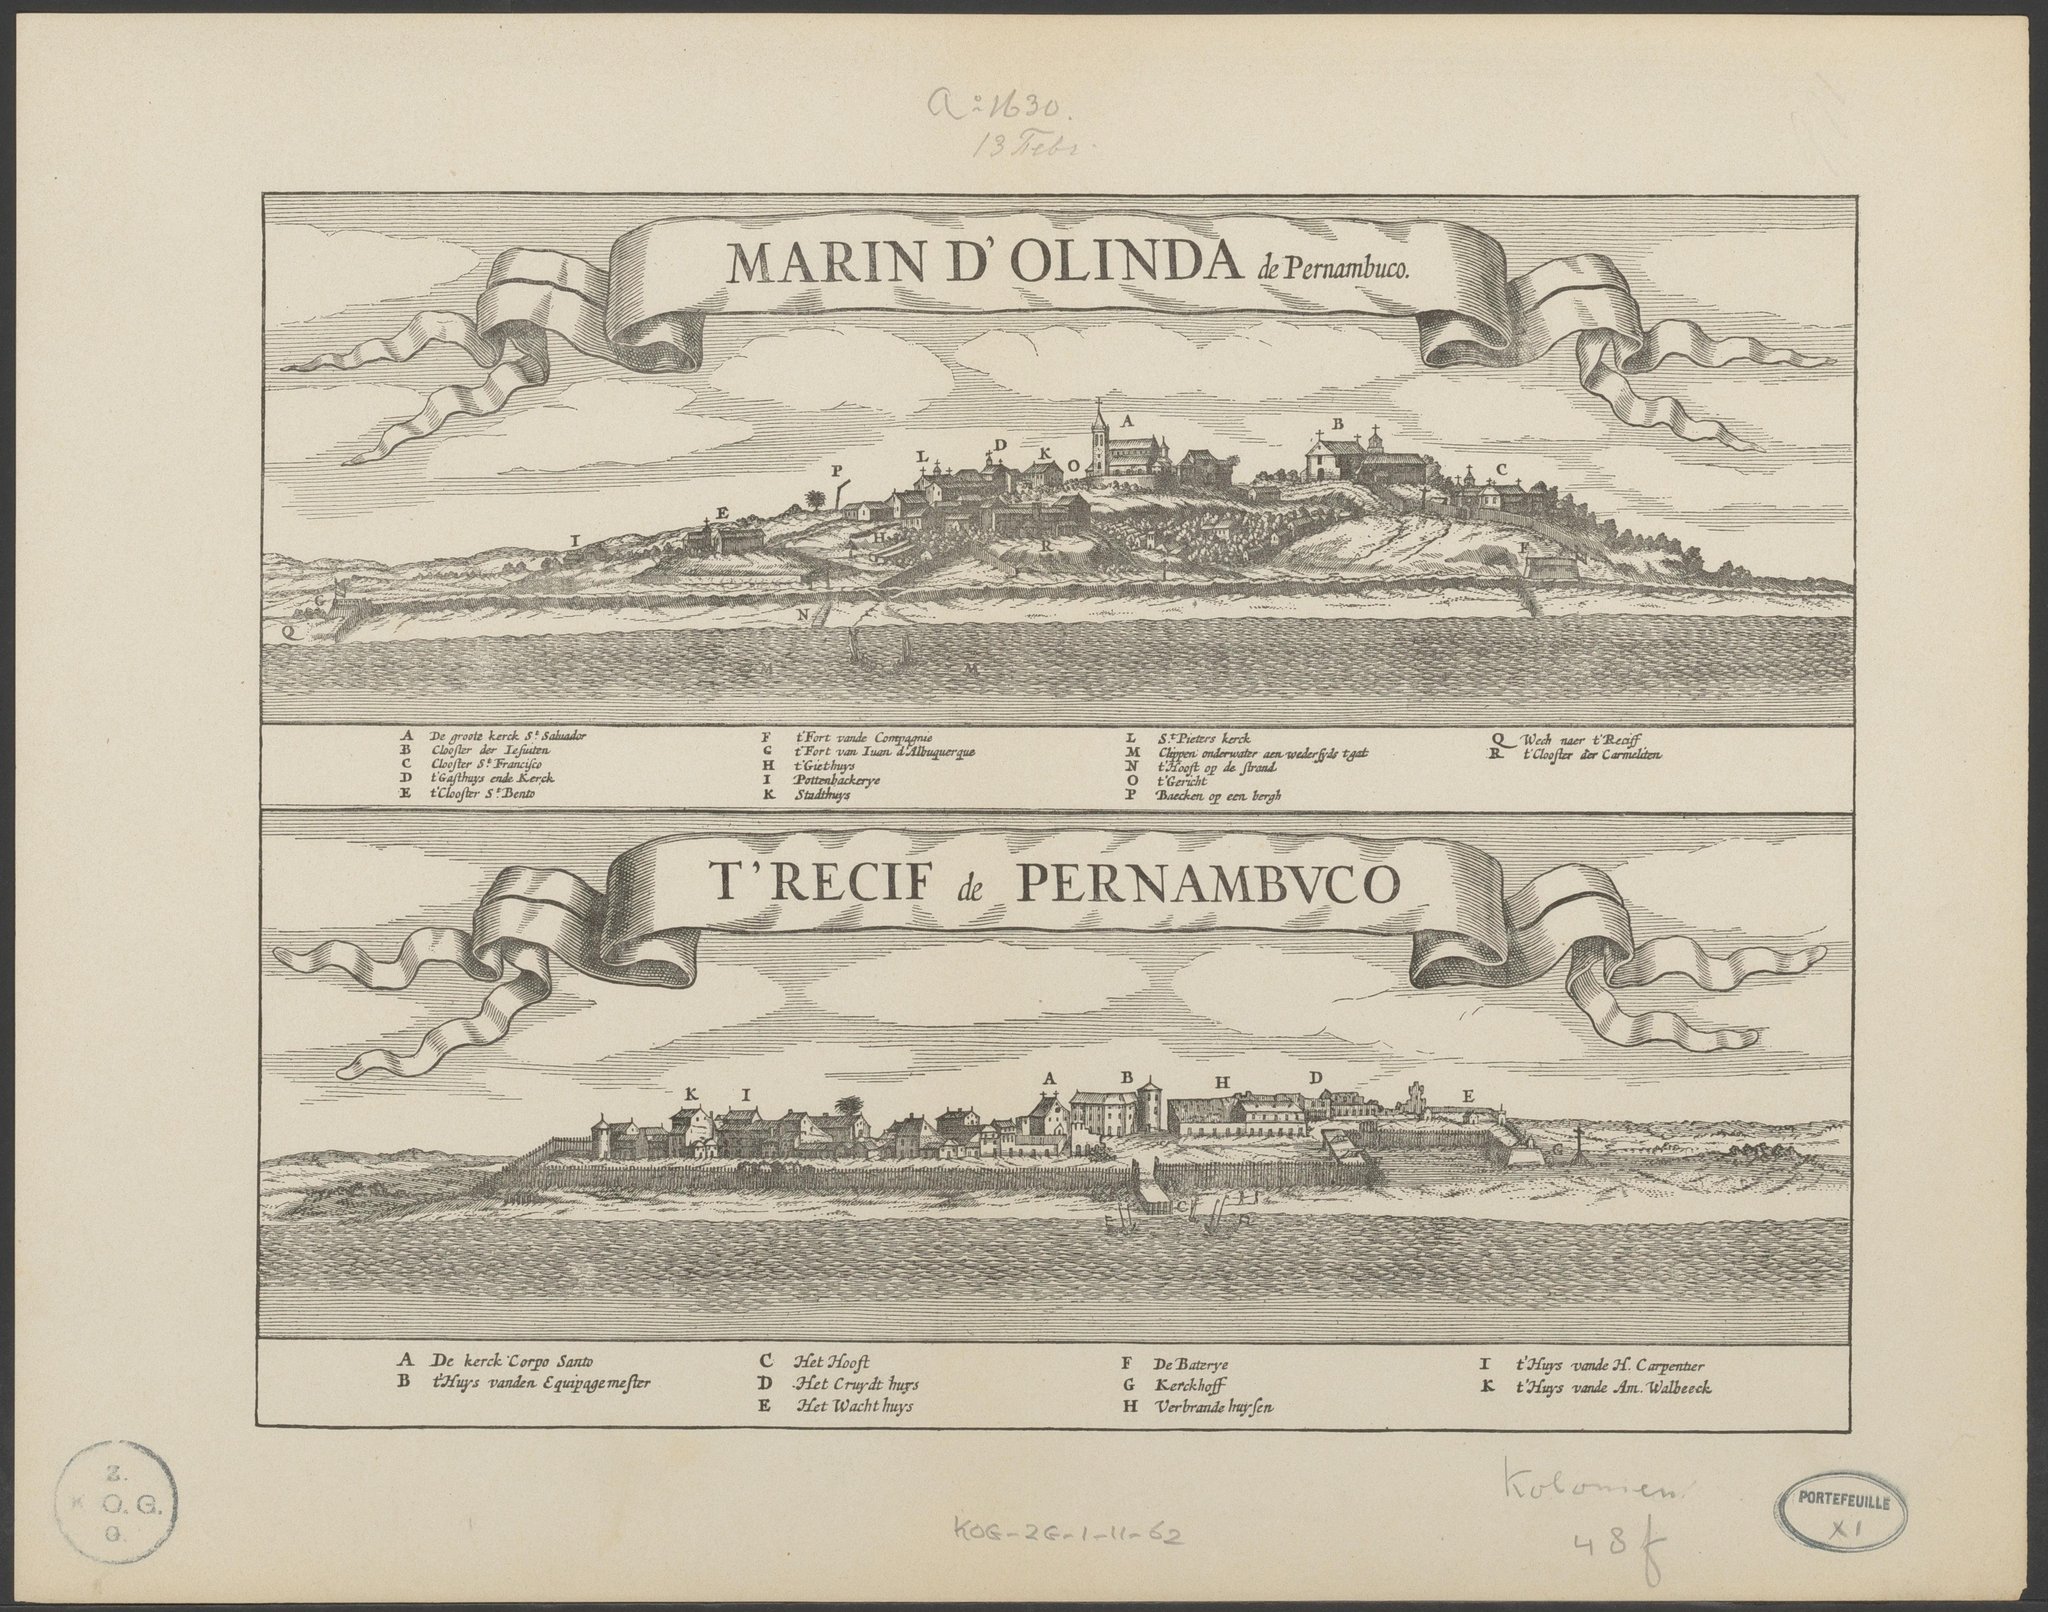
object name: print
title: Twee gezichten op Olinda en Recife te Pernambuco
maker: Anonymous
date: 1800-1899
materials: paper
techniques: lithograph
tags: harbour, fortress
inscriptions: stamp, collector's mark: Lugt 1641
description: Twee gezichten, bovenaan de haven van Olinda en Recife in Permambuco. Onderaan elk gezicht een legenda van de gebouwen op prent. Onderwerpsrubrieken binnen de Atlas Zeden en Gewoonten: Handel, nijverheid en verkeer, Koophandel, Handel op de Koloniën.